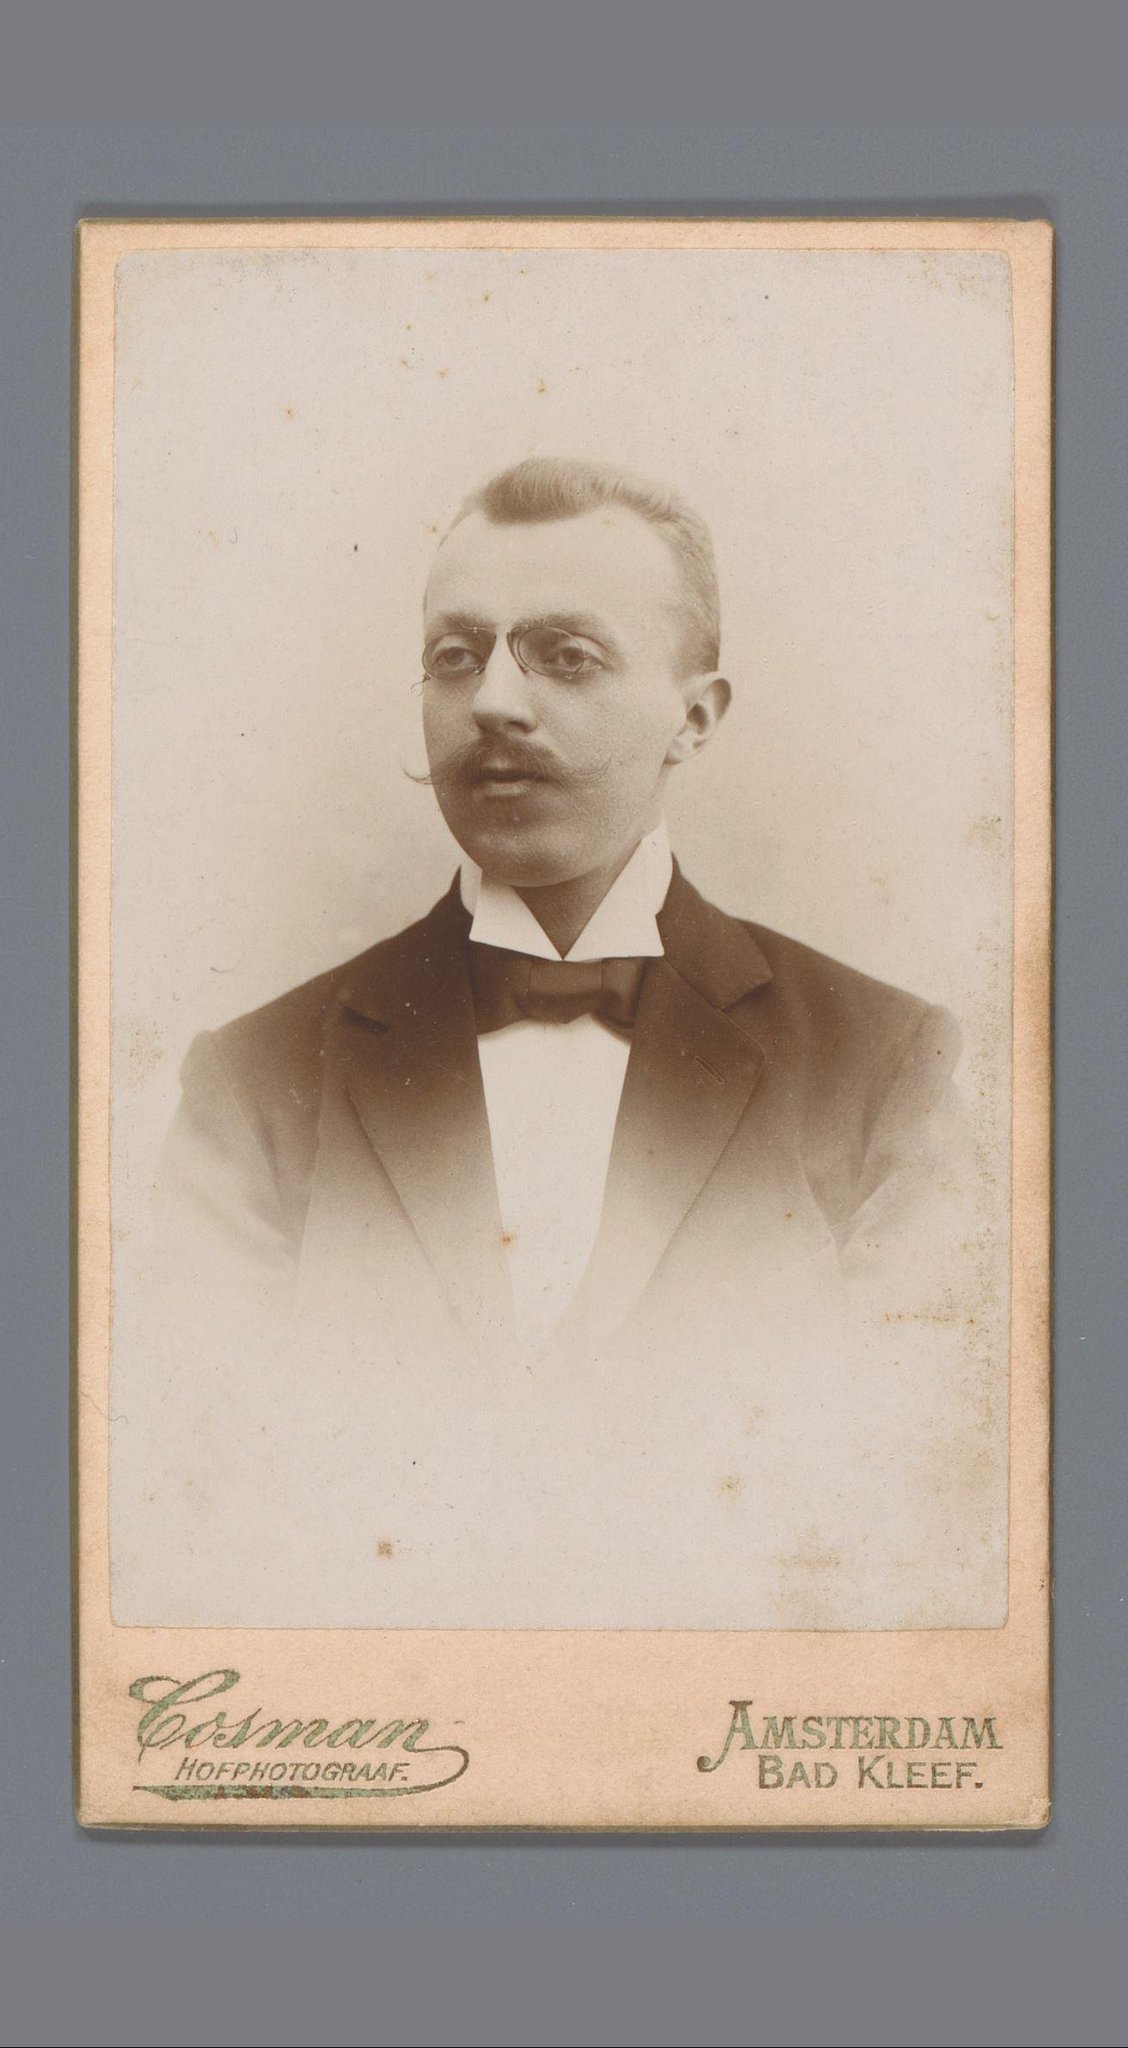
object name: carte de visite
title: Portret van F. H. van den Helm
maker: max cosman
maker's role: fotograaf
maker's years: 1852-1894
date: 1881-1903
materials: paper, cardboard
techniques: collodion silver print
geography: amsterdam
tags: adult man, historical persons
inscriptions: inscription: ‘Specialiteit/ in/ Vergrootingen. Kooldruk Onveranderlijk./ De plaat blijft voor nabestelling bewaard.’, address: ‘Amsterdam/ Galerij 48./ Filiaal Bad Kleef.’